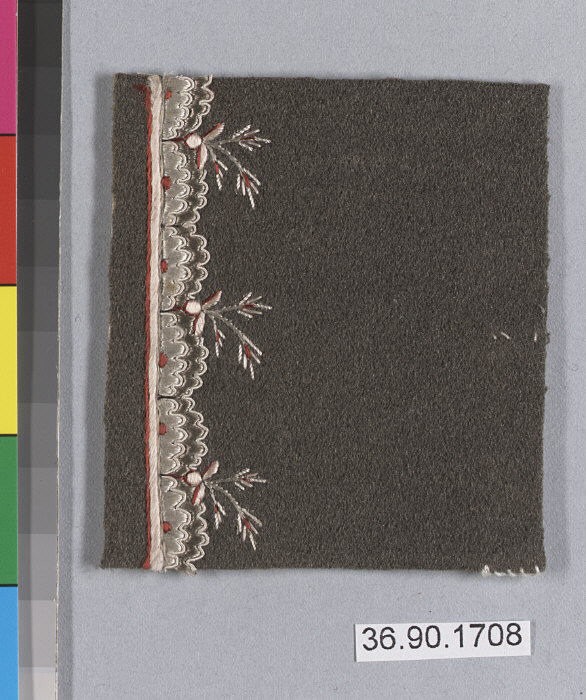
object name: sample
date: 1801-1833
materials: felt, silk